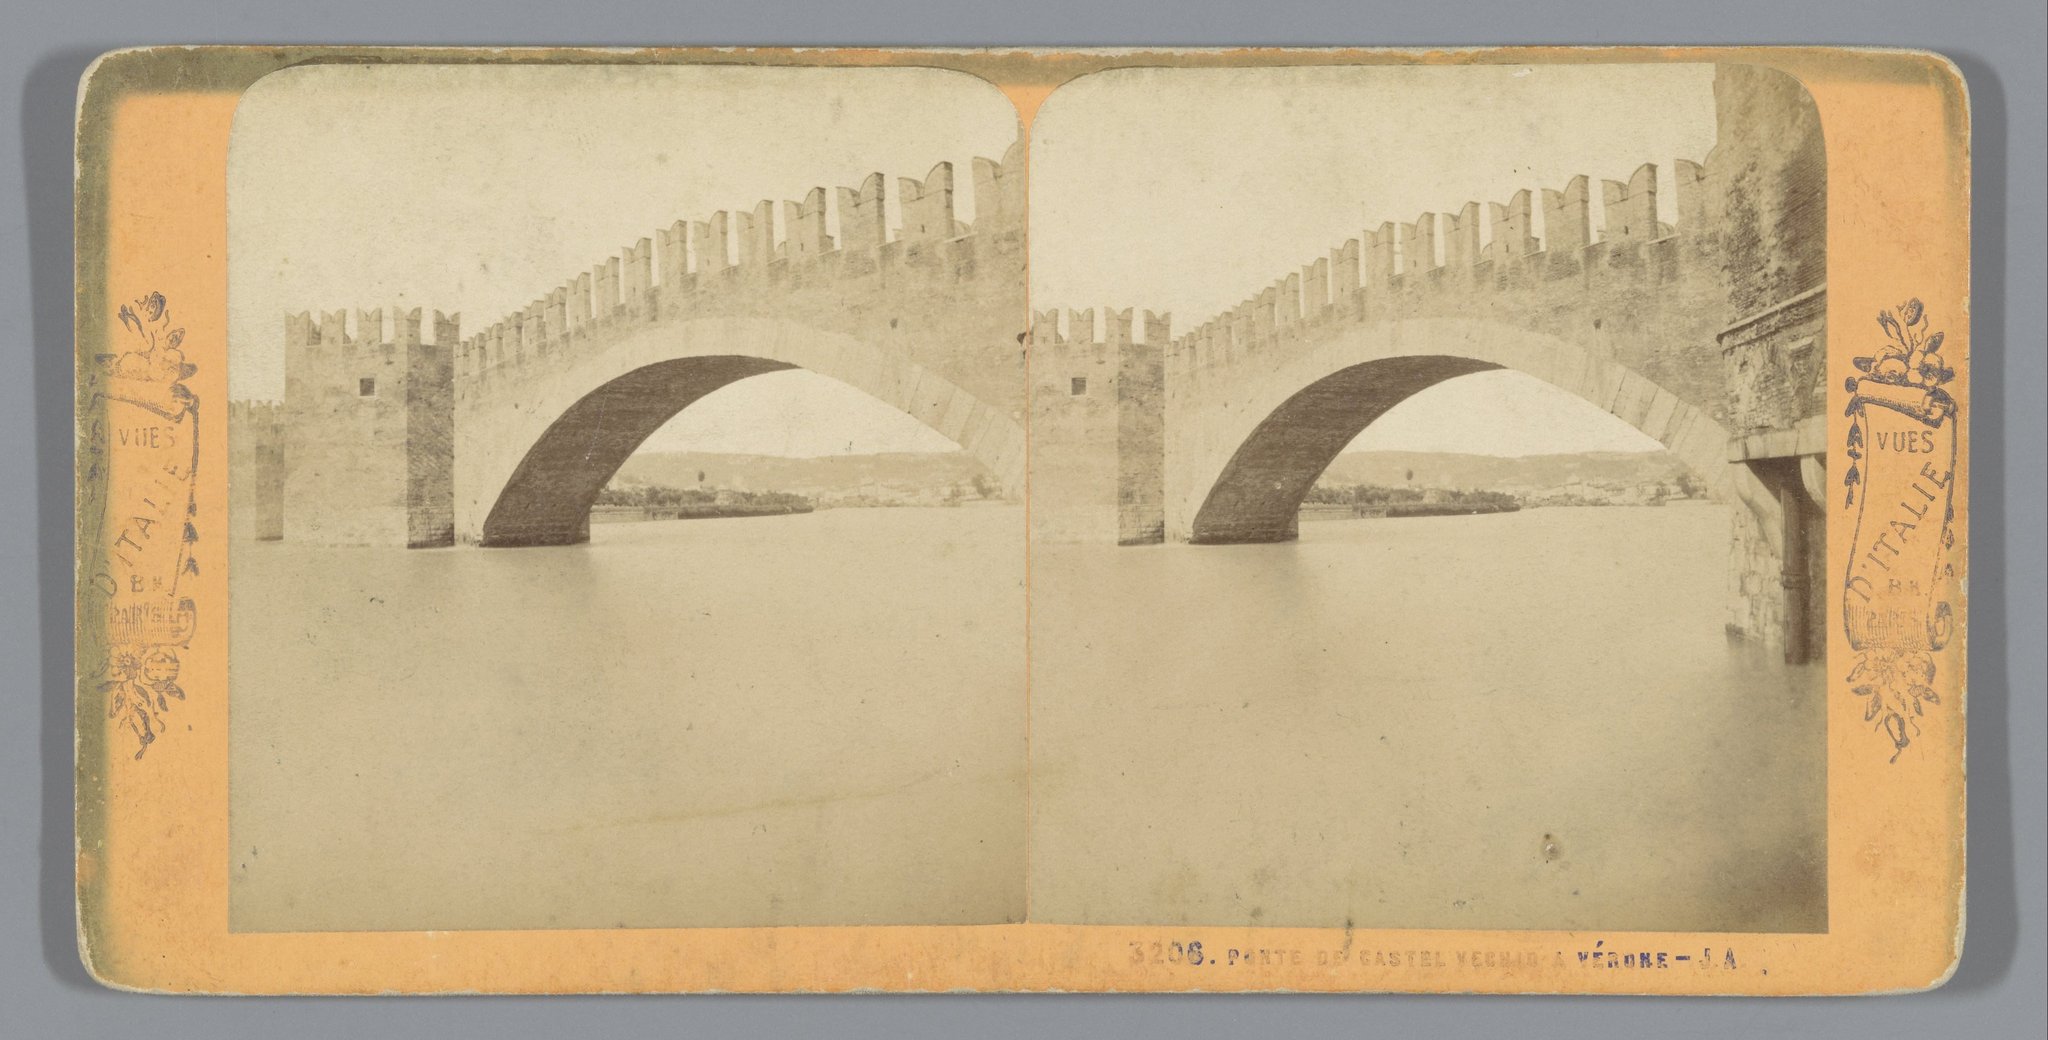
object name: stereograph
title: Ponte de Castel Vechio a Vérone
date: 1872-1876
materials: cardboard, paper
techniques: albumen print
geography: paris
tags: bridge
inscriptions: title: ‘No 3206/ verona. brug van castel vecchio’, number: ‘3206’